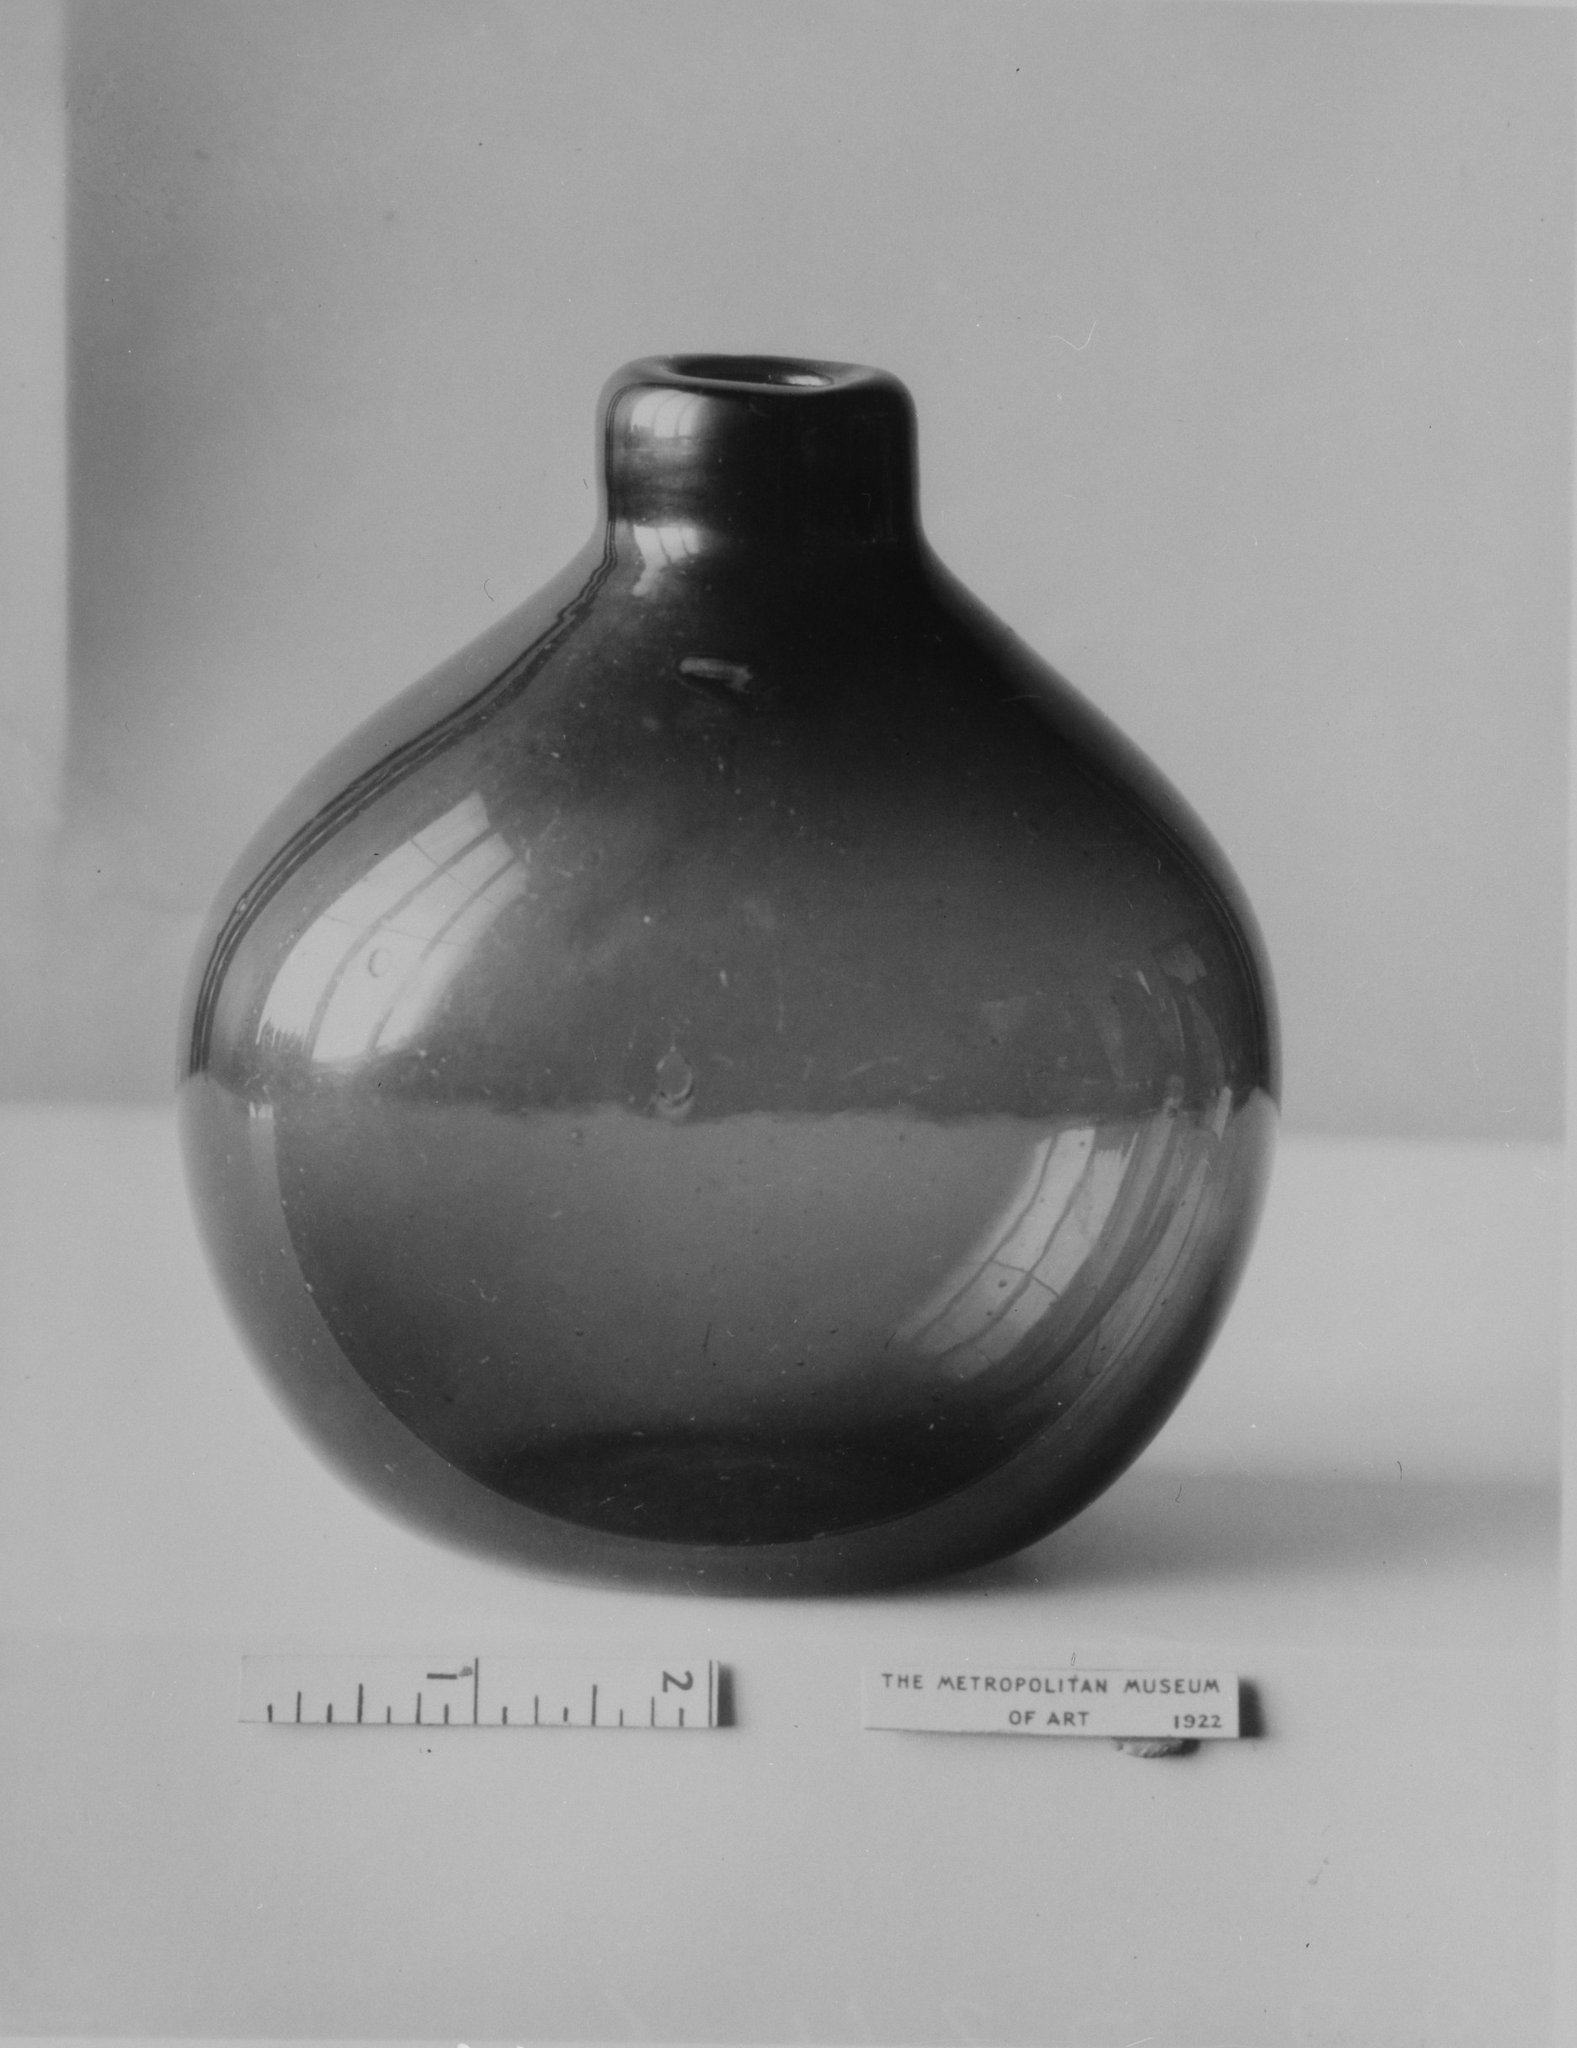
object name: flask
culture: american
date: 1700-1800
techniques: glassblowing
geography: united states